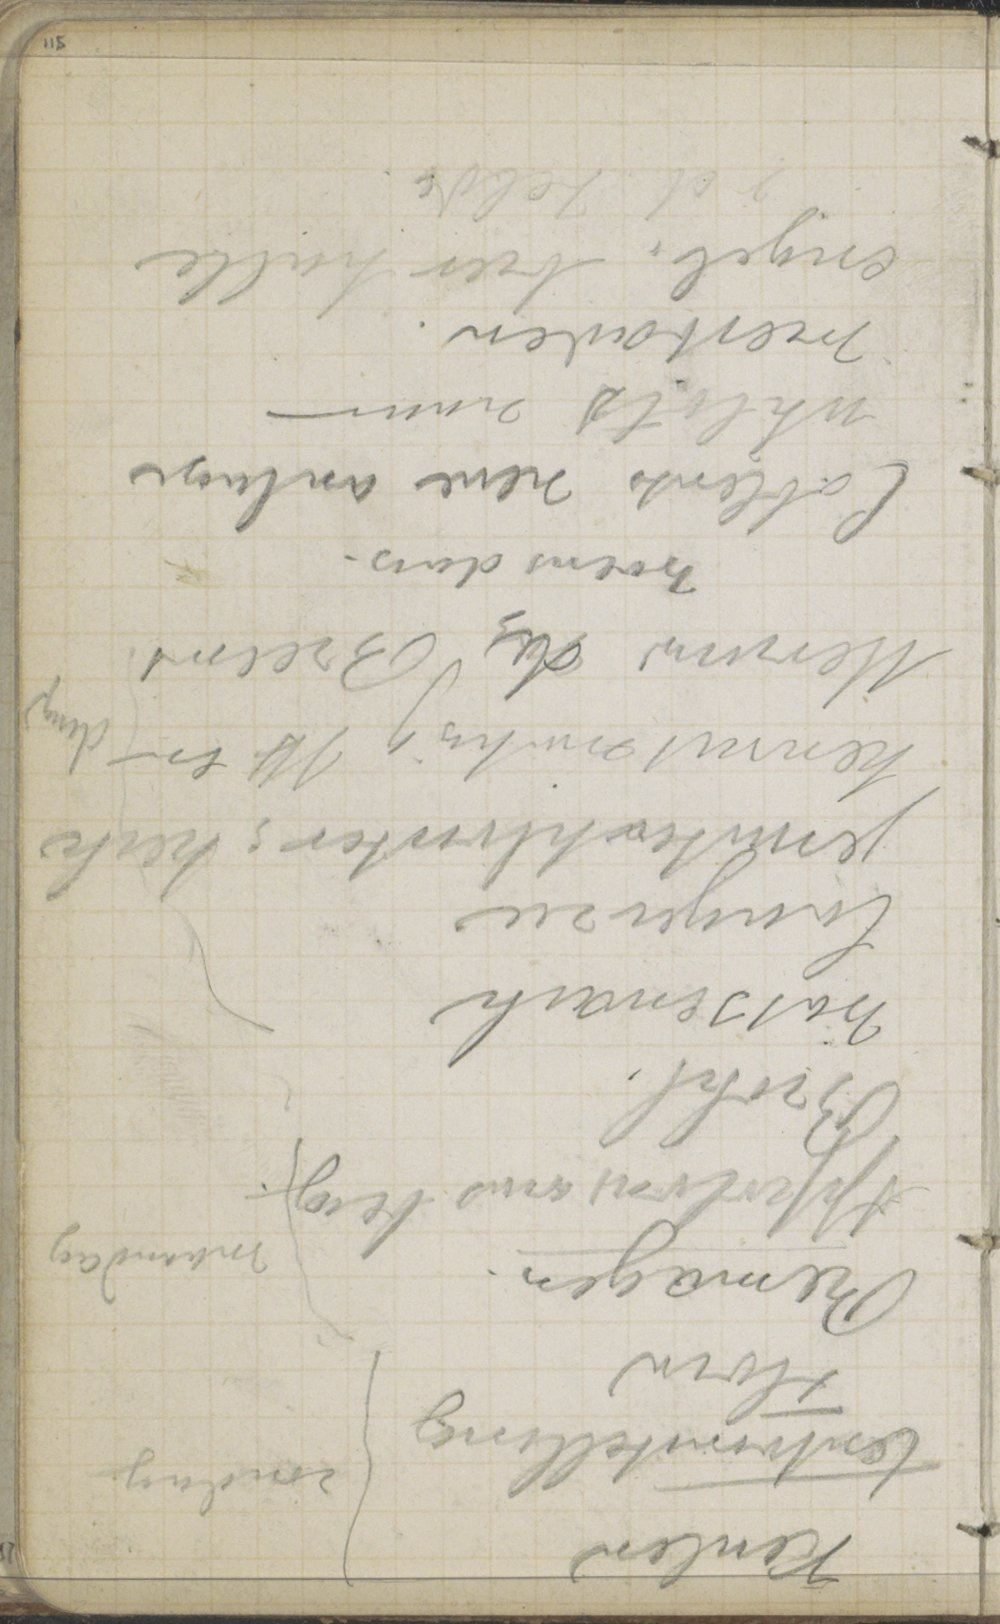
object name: sketchbook leaf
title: Blad met notities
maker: marius bauer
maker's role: draughtsman, print maker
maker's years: 1867-1932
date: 1879-1885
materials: pencil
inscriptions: annotation: ‘[...]’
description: Pagina 115 uit een schetsboek met 58 bladen.